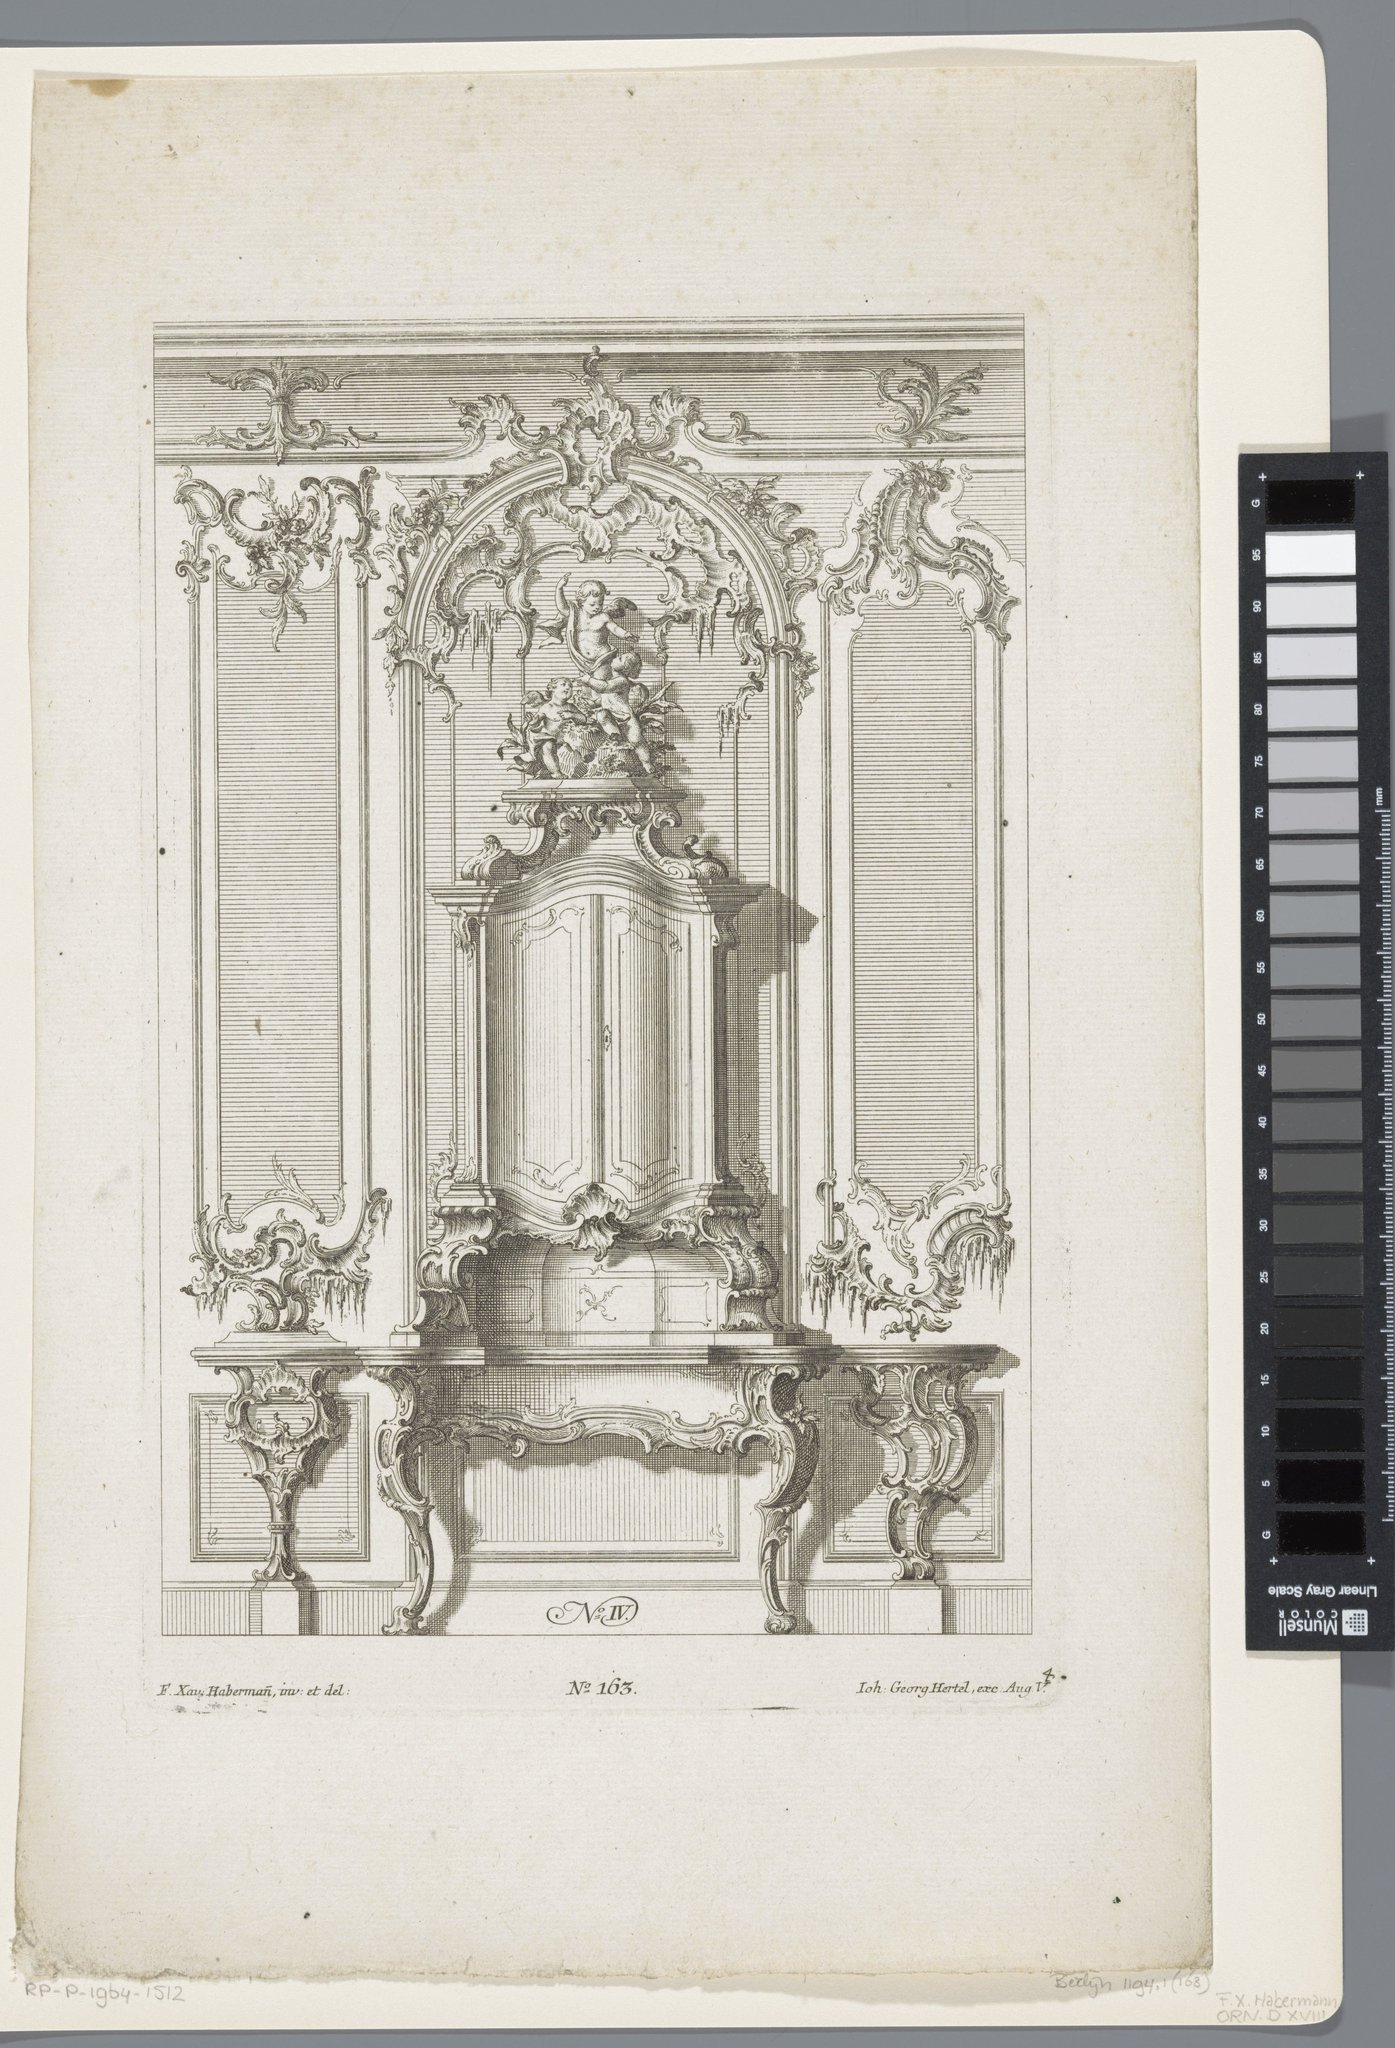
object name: print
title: Schrijftafels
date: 1731-1775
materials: paper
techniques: engraving, etching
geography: augsburg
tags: writing-table, writing-desk, rocaille ornament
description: Schrijftafel met rocaille ornamenten en drie gevleugelde putti. Uitgeversnummer 163.